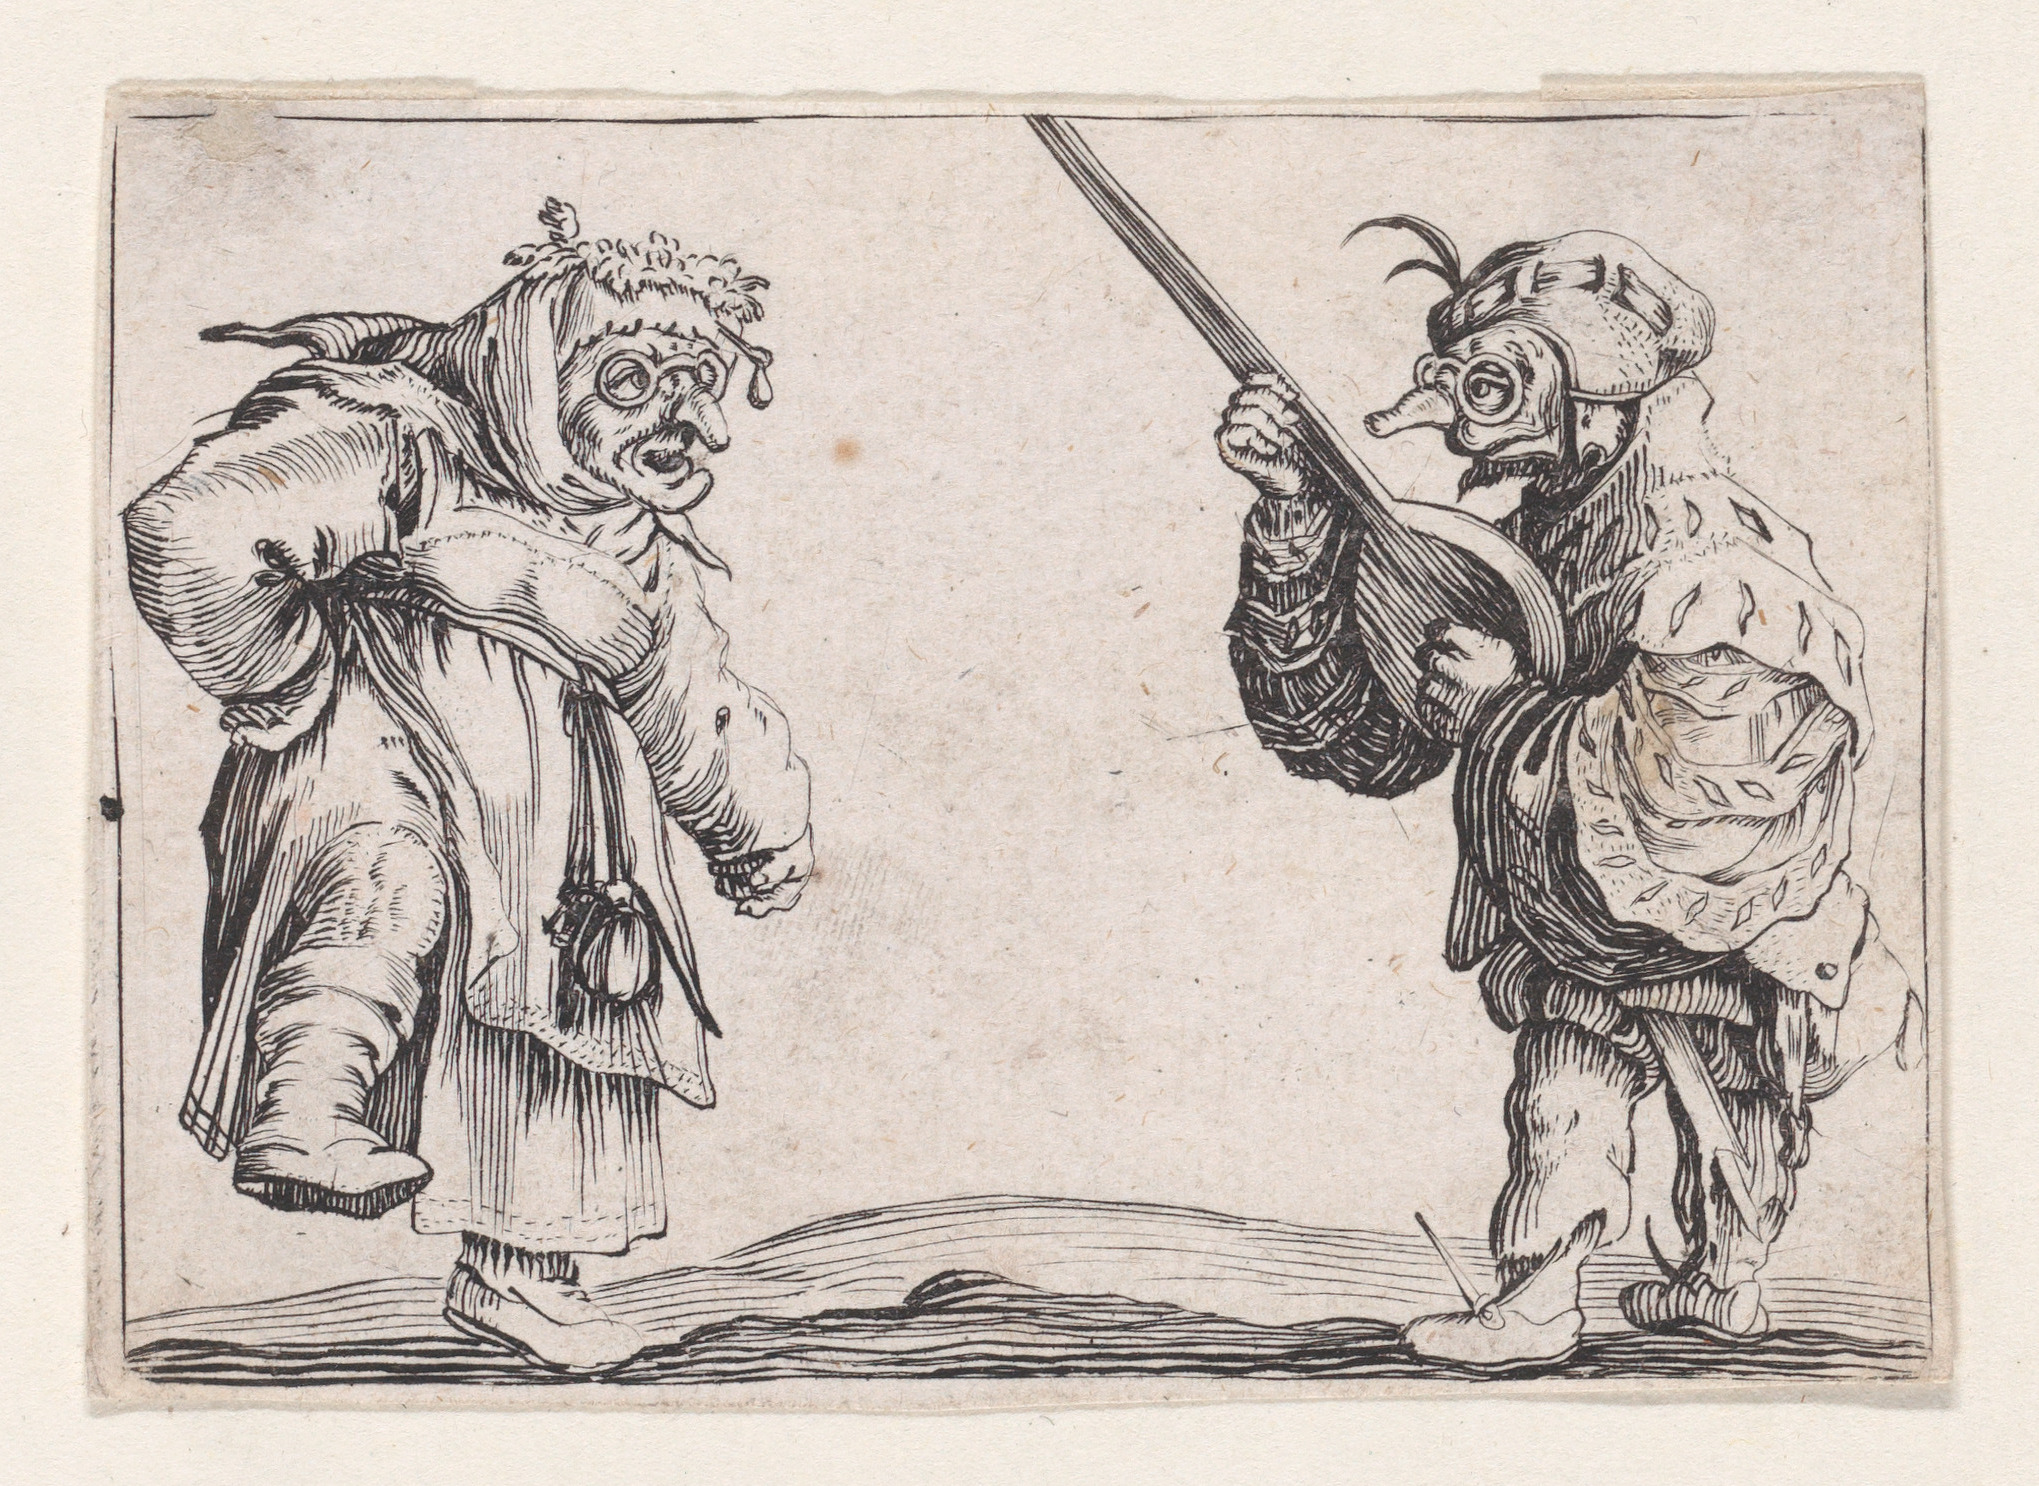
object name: print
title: Copy of Les Danseurs Au Luth (The Dancers with a Lute), from "Les Caprices"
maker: Anonymous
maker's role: artist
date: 1601-1700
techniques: etching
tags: lutes,dancers